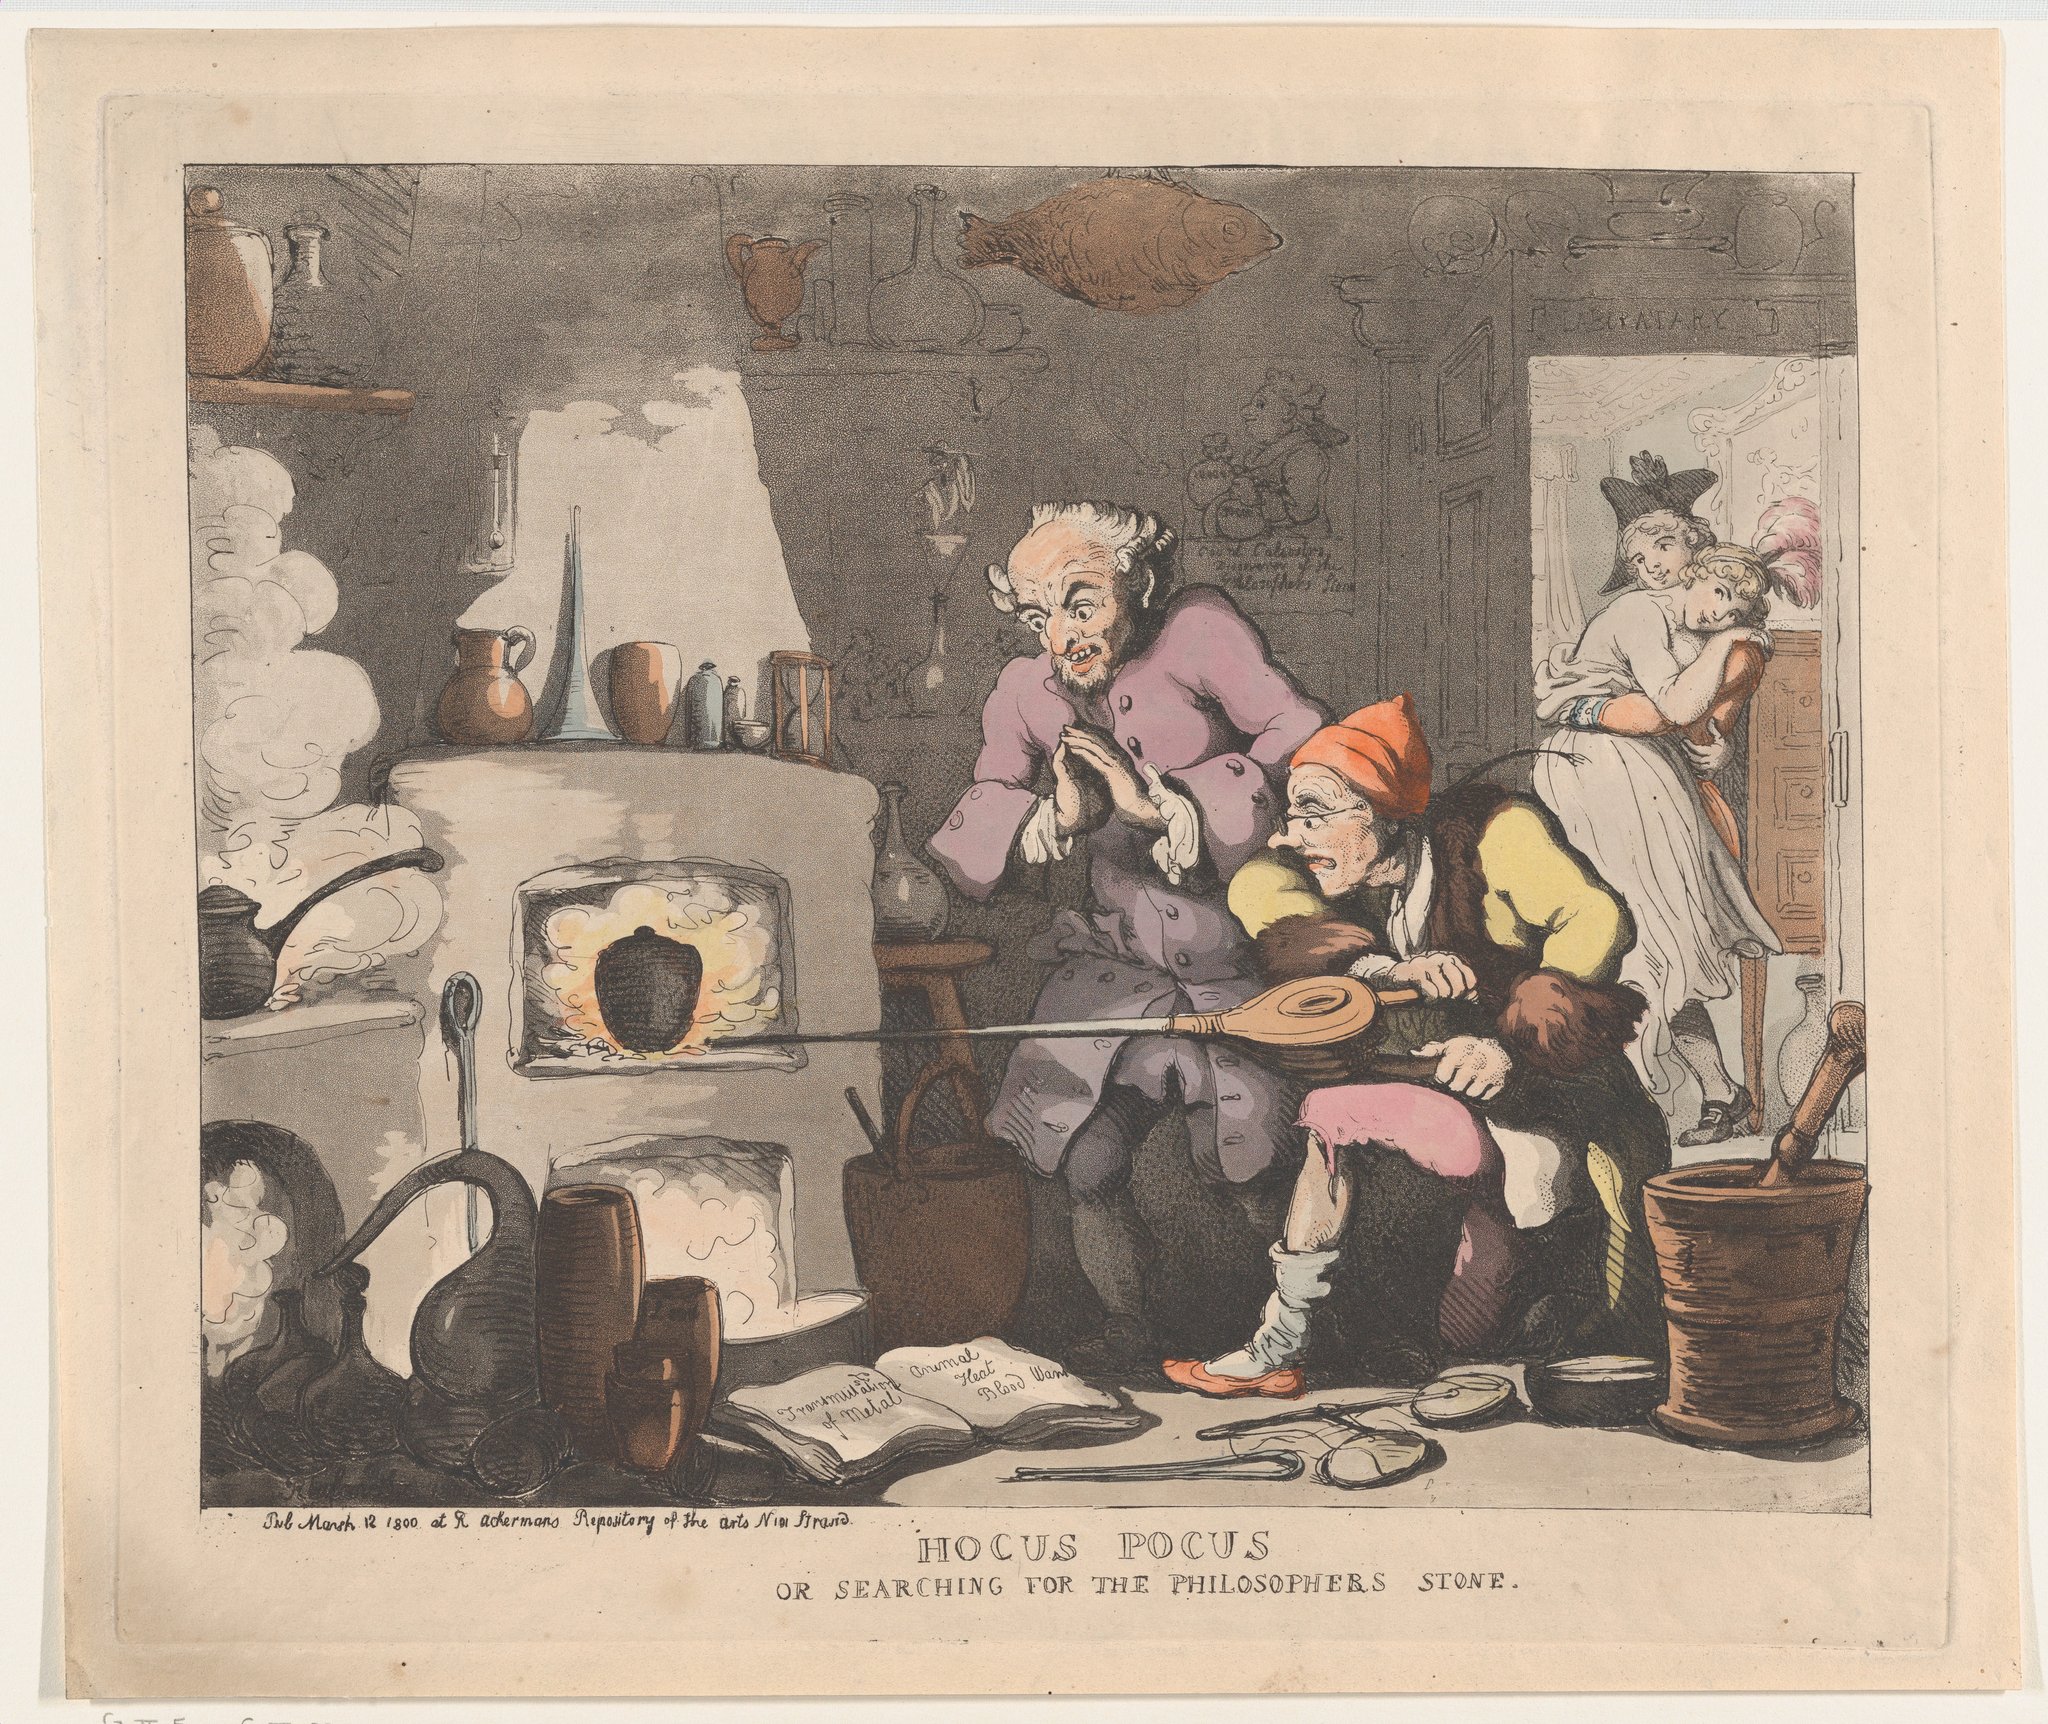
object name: print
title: Hocus Pocus, or Searching for the Philsopher's Stone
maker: thomas rowlandson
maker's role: artist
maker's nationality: british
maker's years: 1757-1827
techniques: aquatint, etching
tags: fireplaces,couples,men,women